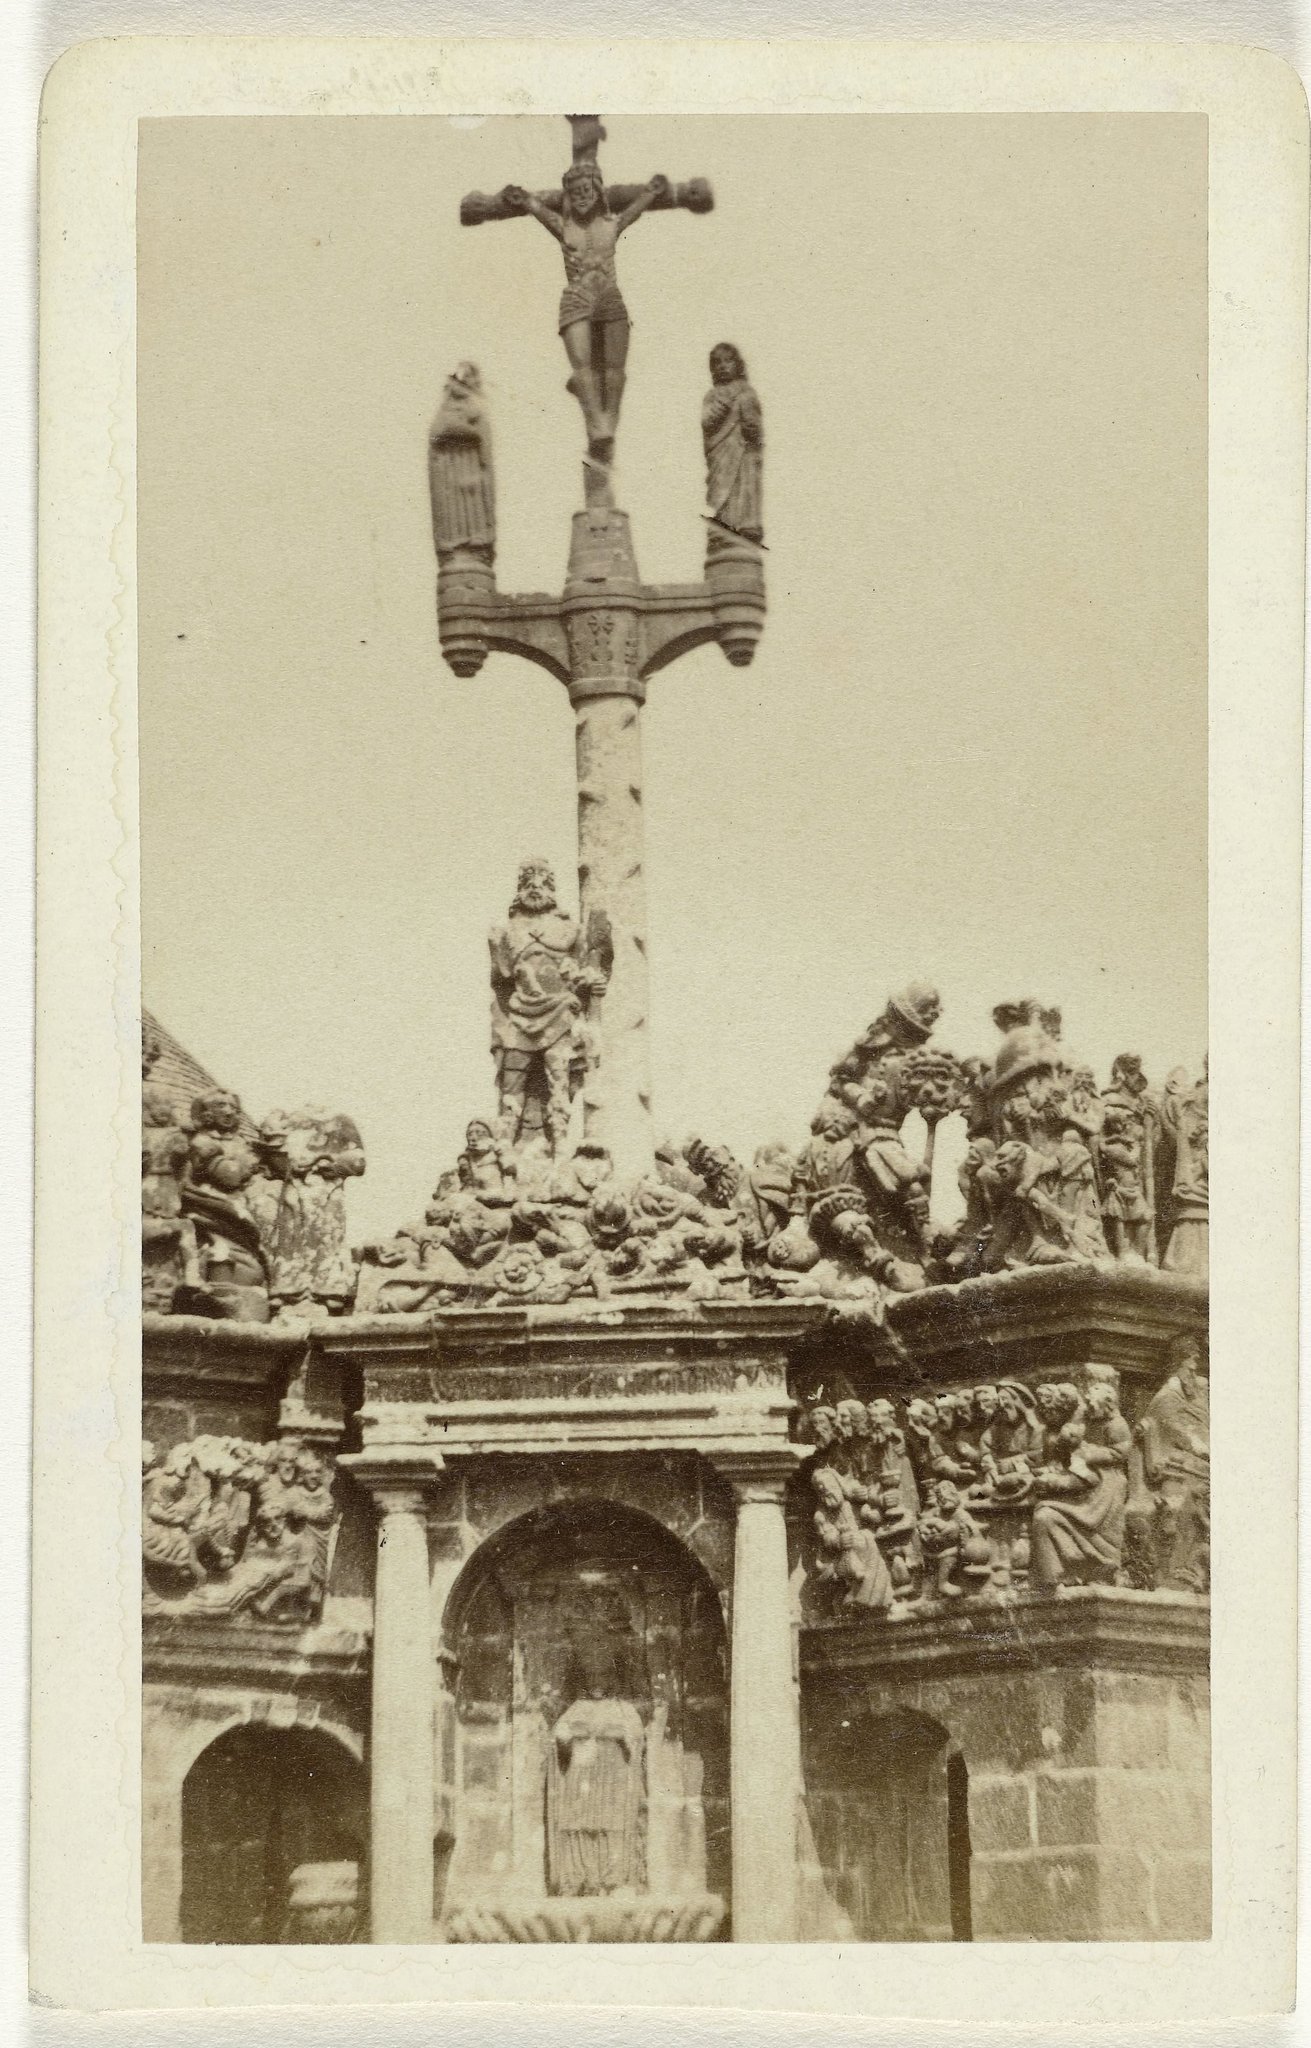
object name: photograph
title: Voyage en Bretagne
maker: Anonymous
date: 1865-1880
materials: cardboard, paper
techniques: albumen print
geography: france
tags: guimiliau, calvaire, bretagne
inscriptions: annotation: ‘Finistère’, title: ‘VOYAGE EN BRETAGNE’, annotation: ‘Calvaire de Gumiliau / 8 juillet’